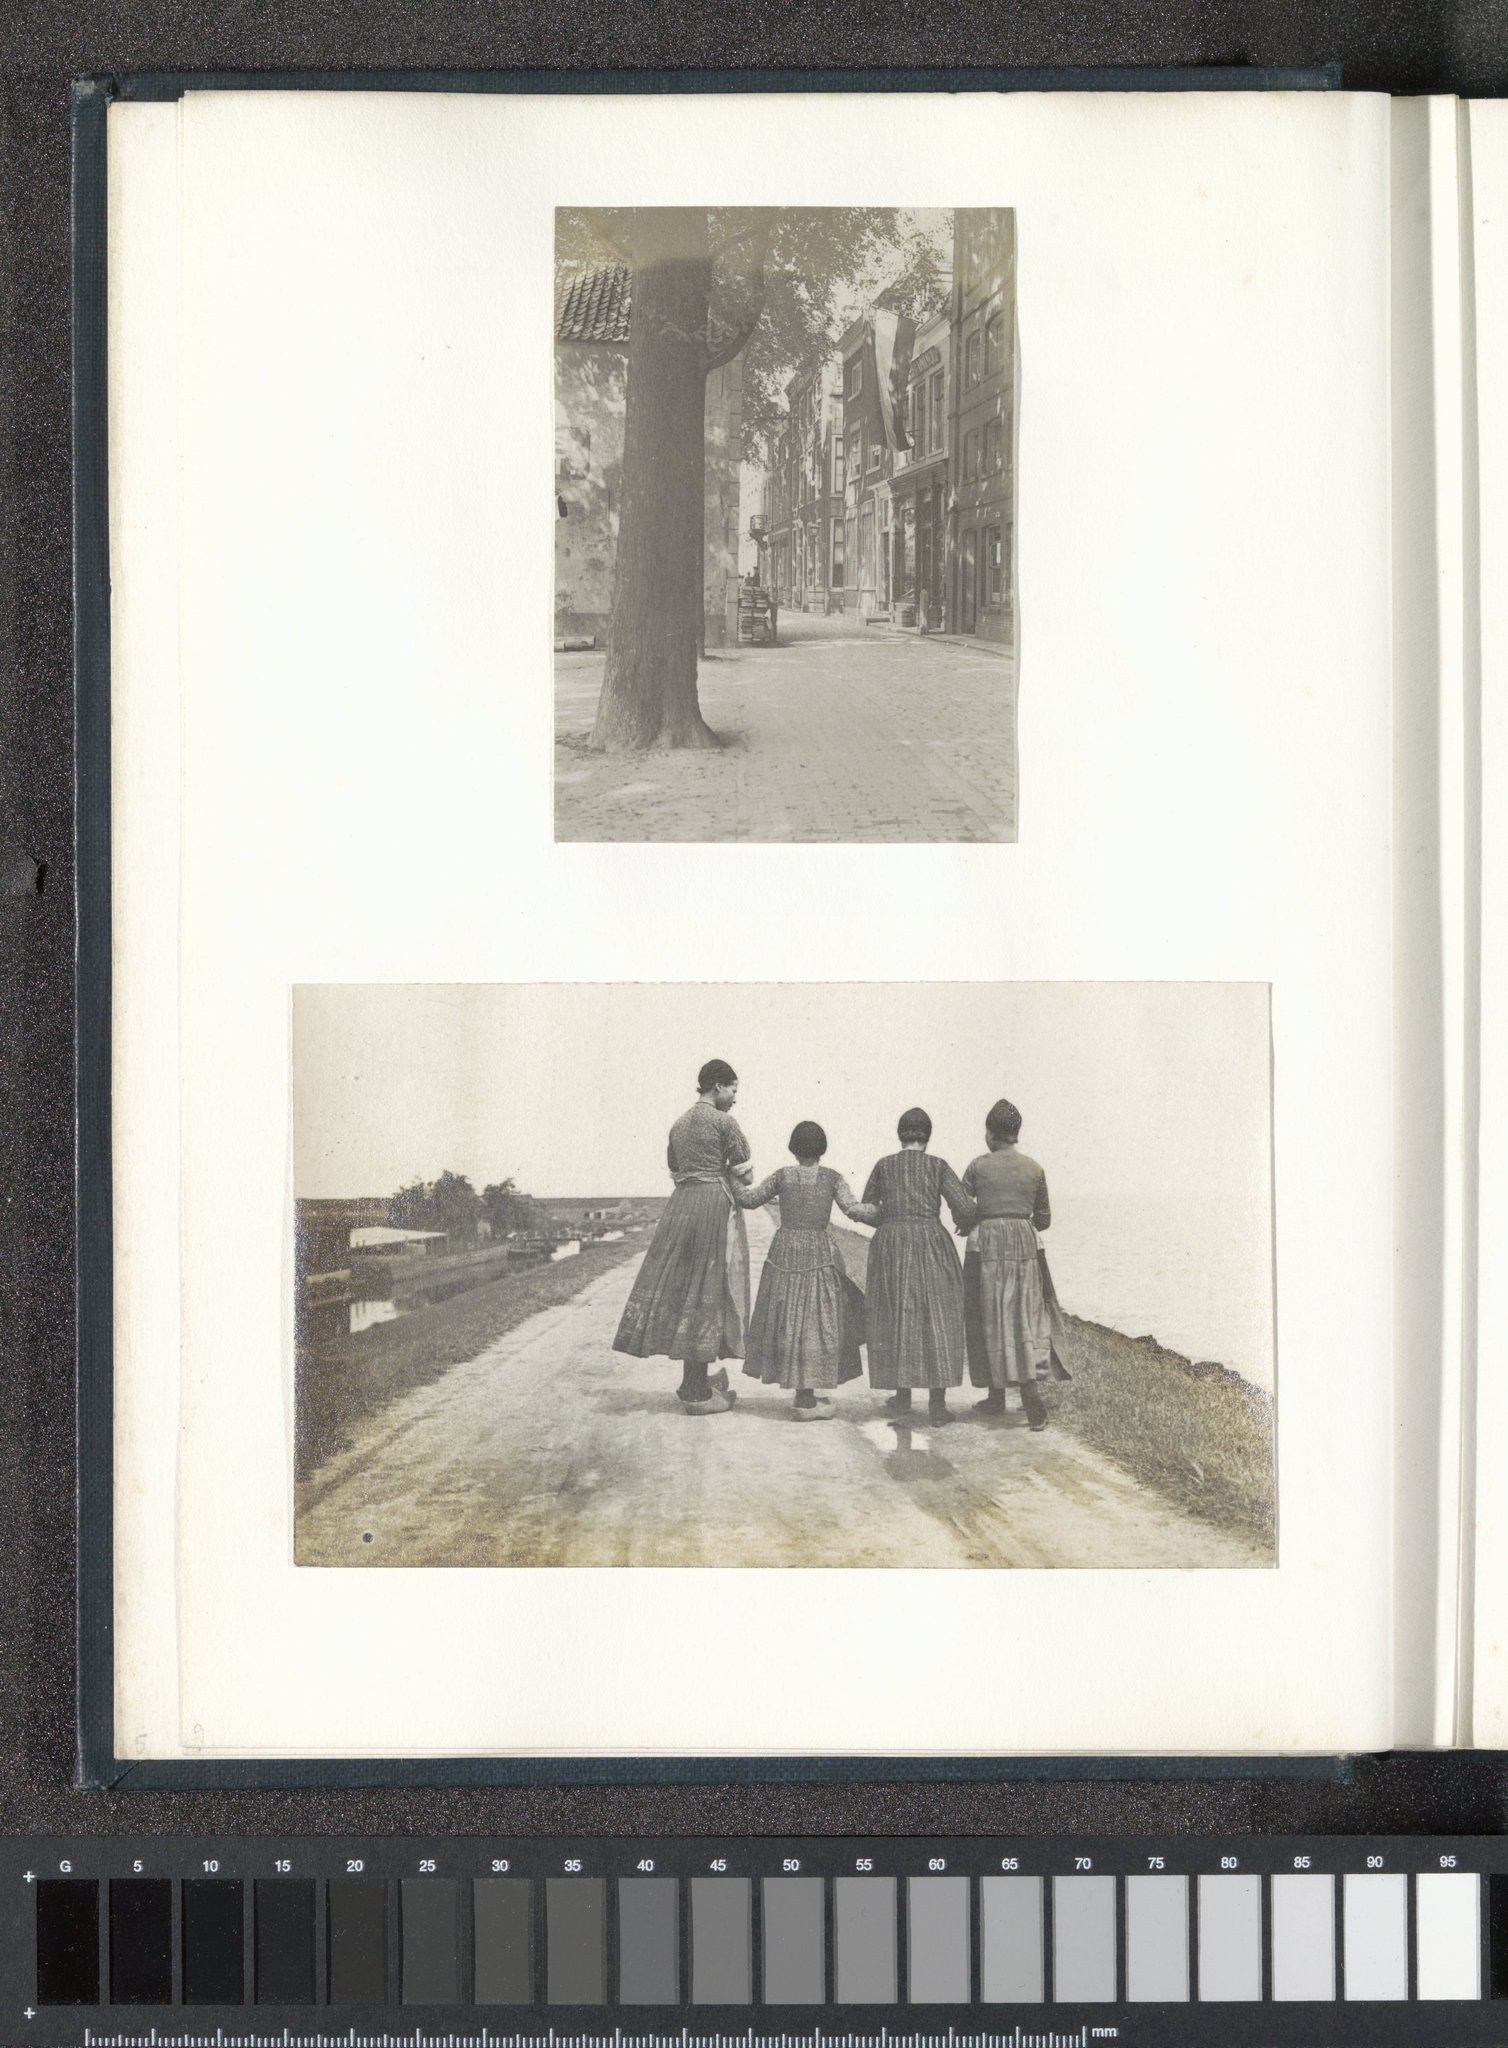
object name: photograph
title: Gezicht op de Appeldijk te Gorinchem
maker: george hidderley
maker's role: fotograaf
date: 1900-1910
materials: paper, photographic support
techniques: gelatin silver print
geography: volendam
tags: flags flown from a mast, village street, the usual house or row of houses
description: Onderdeel van fotoalbum met opnames van Volendam, Dordrecht, Gorinchem en Woudrichem.